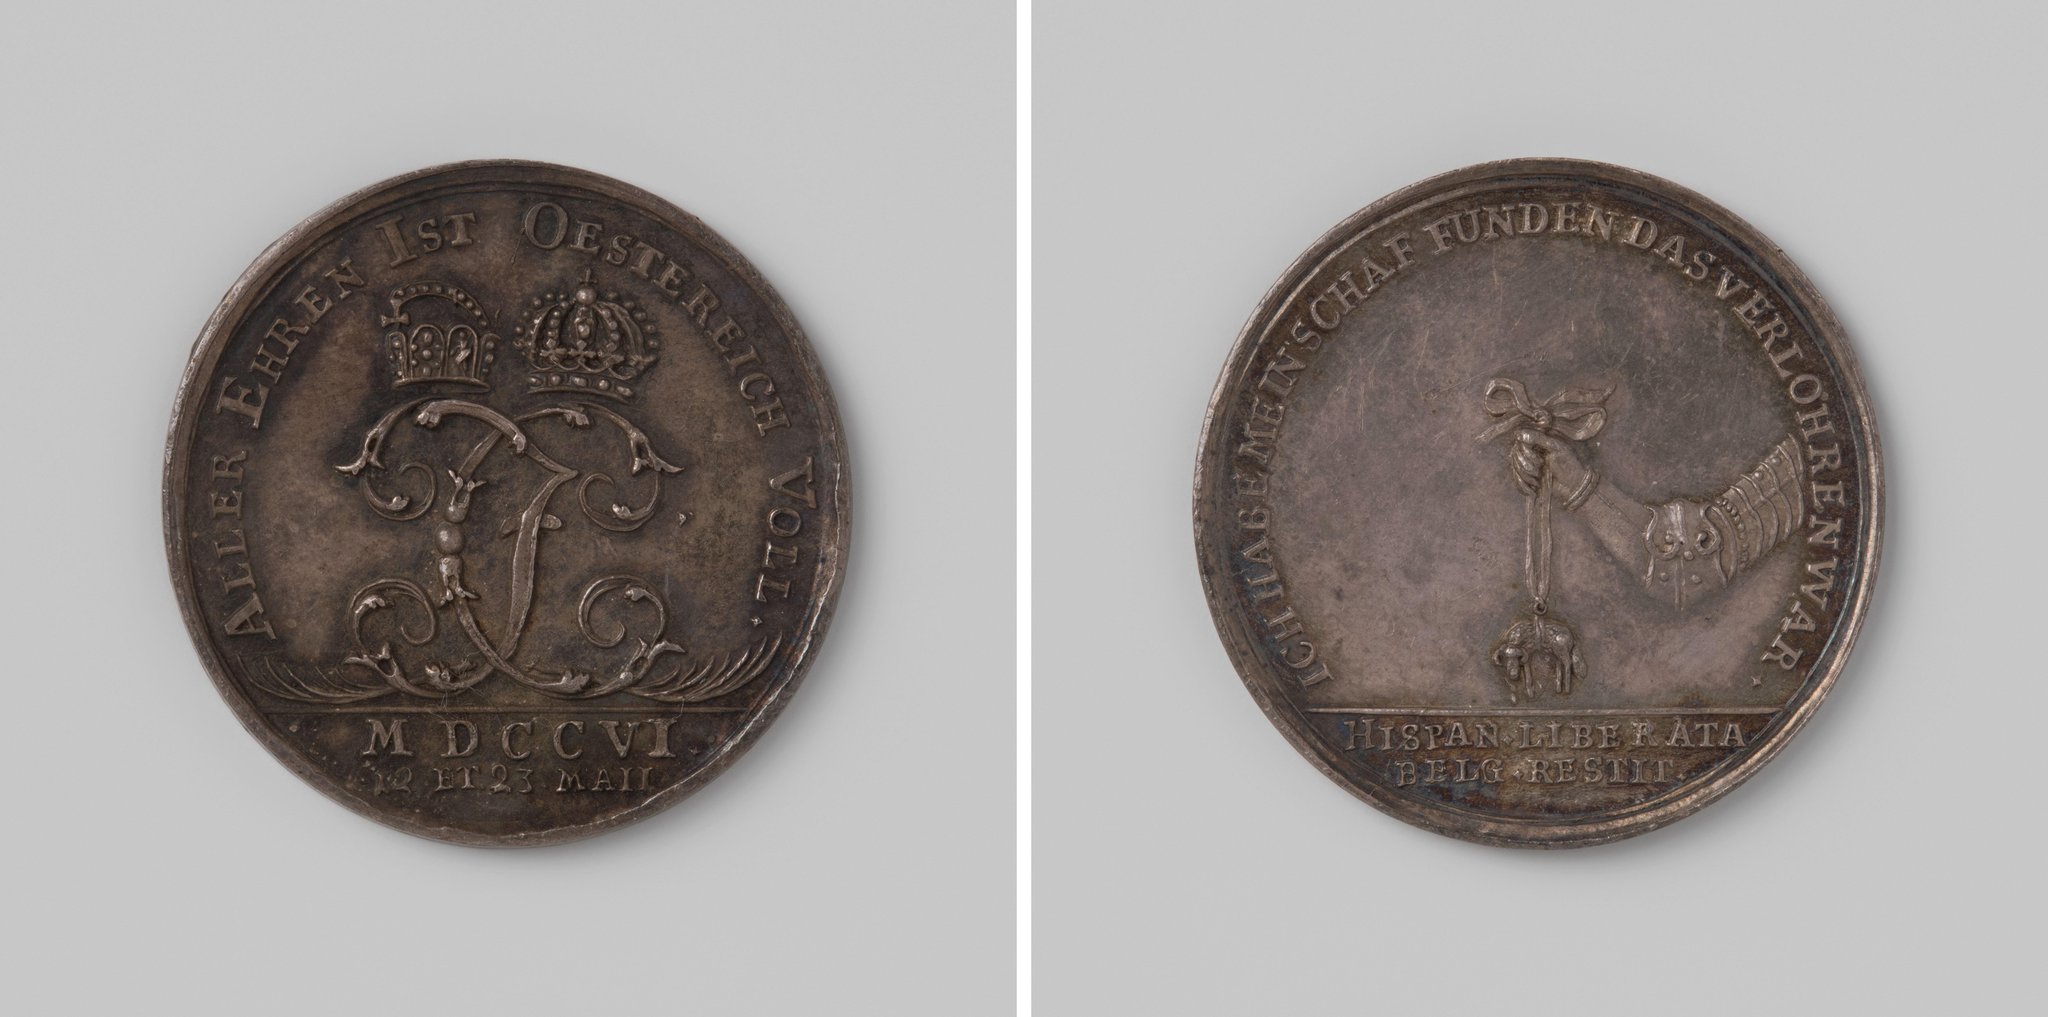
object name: jeton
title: Ontzet van Barcelona en slag bij Ramillies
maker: Anonymous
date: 1706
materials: silver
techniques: striking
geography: austria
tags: vienna, jozef i (duits keizer), charles vi (holy roman emperor), brabant, spain